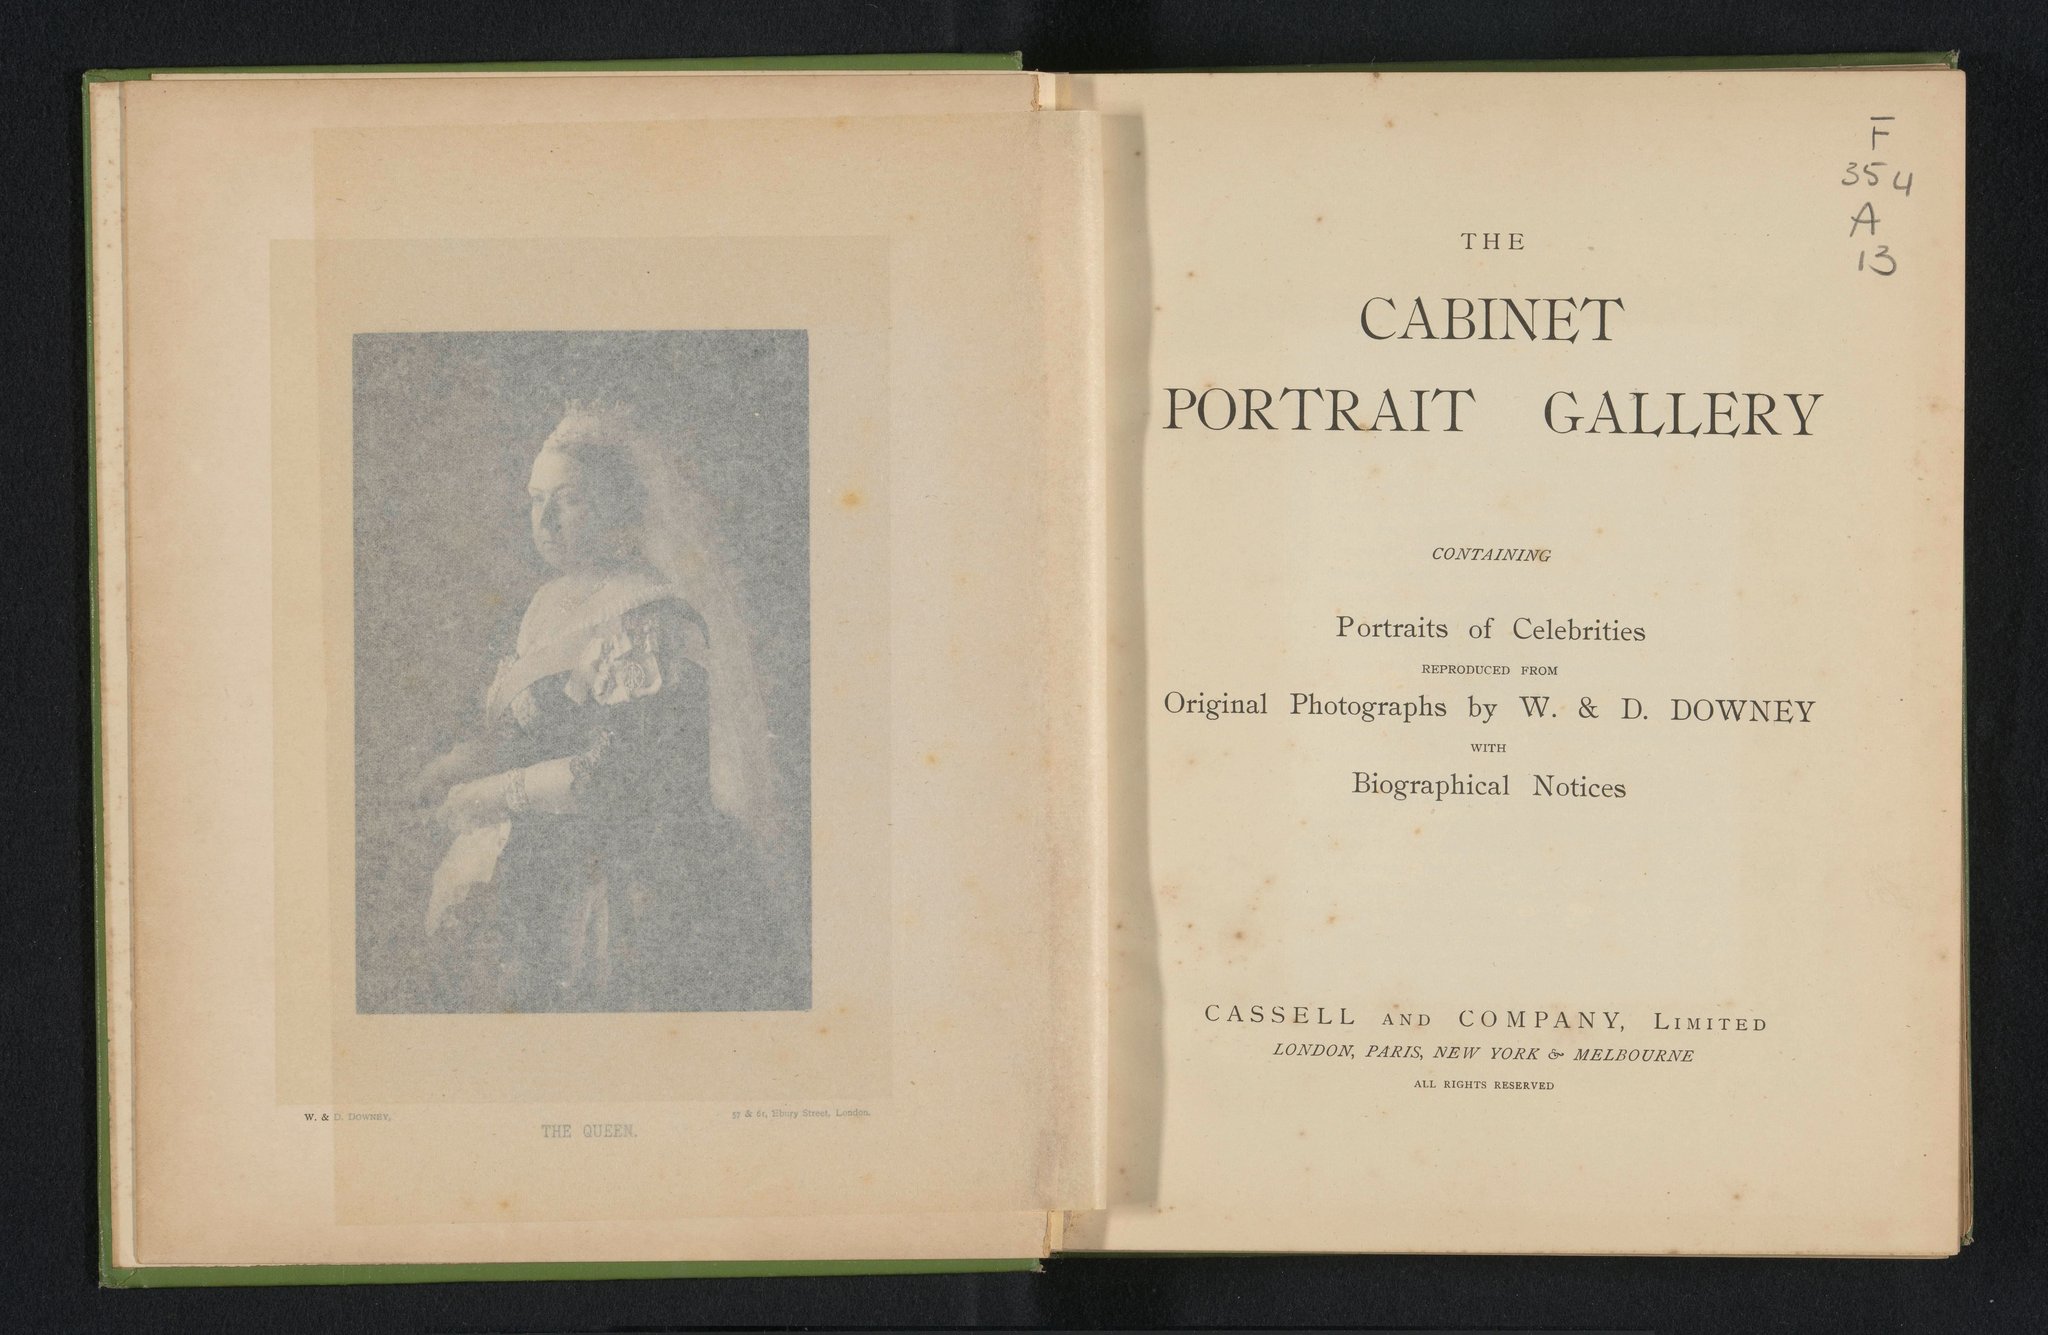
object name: book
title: The cabinet portrait gallery containg portraits of celebrities reproduced from original photographs by W. and D. Downey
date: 1894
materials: linen, paper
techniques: woodburytype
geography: london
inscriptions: inscription: ‘St. Sampson's Wesleyan P.S.A. Prize Miss [...]’